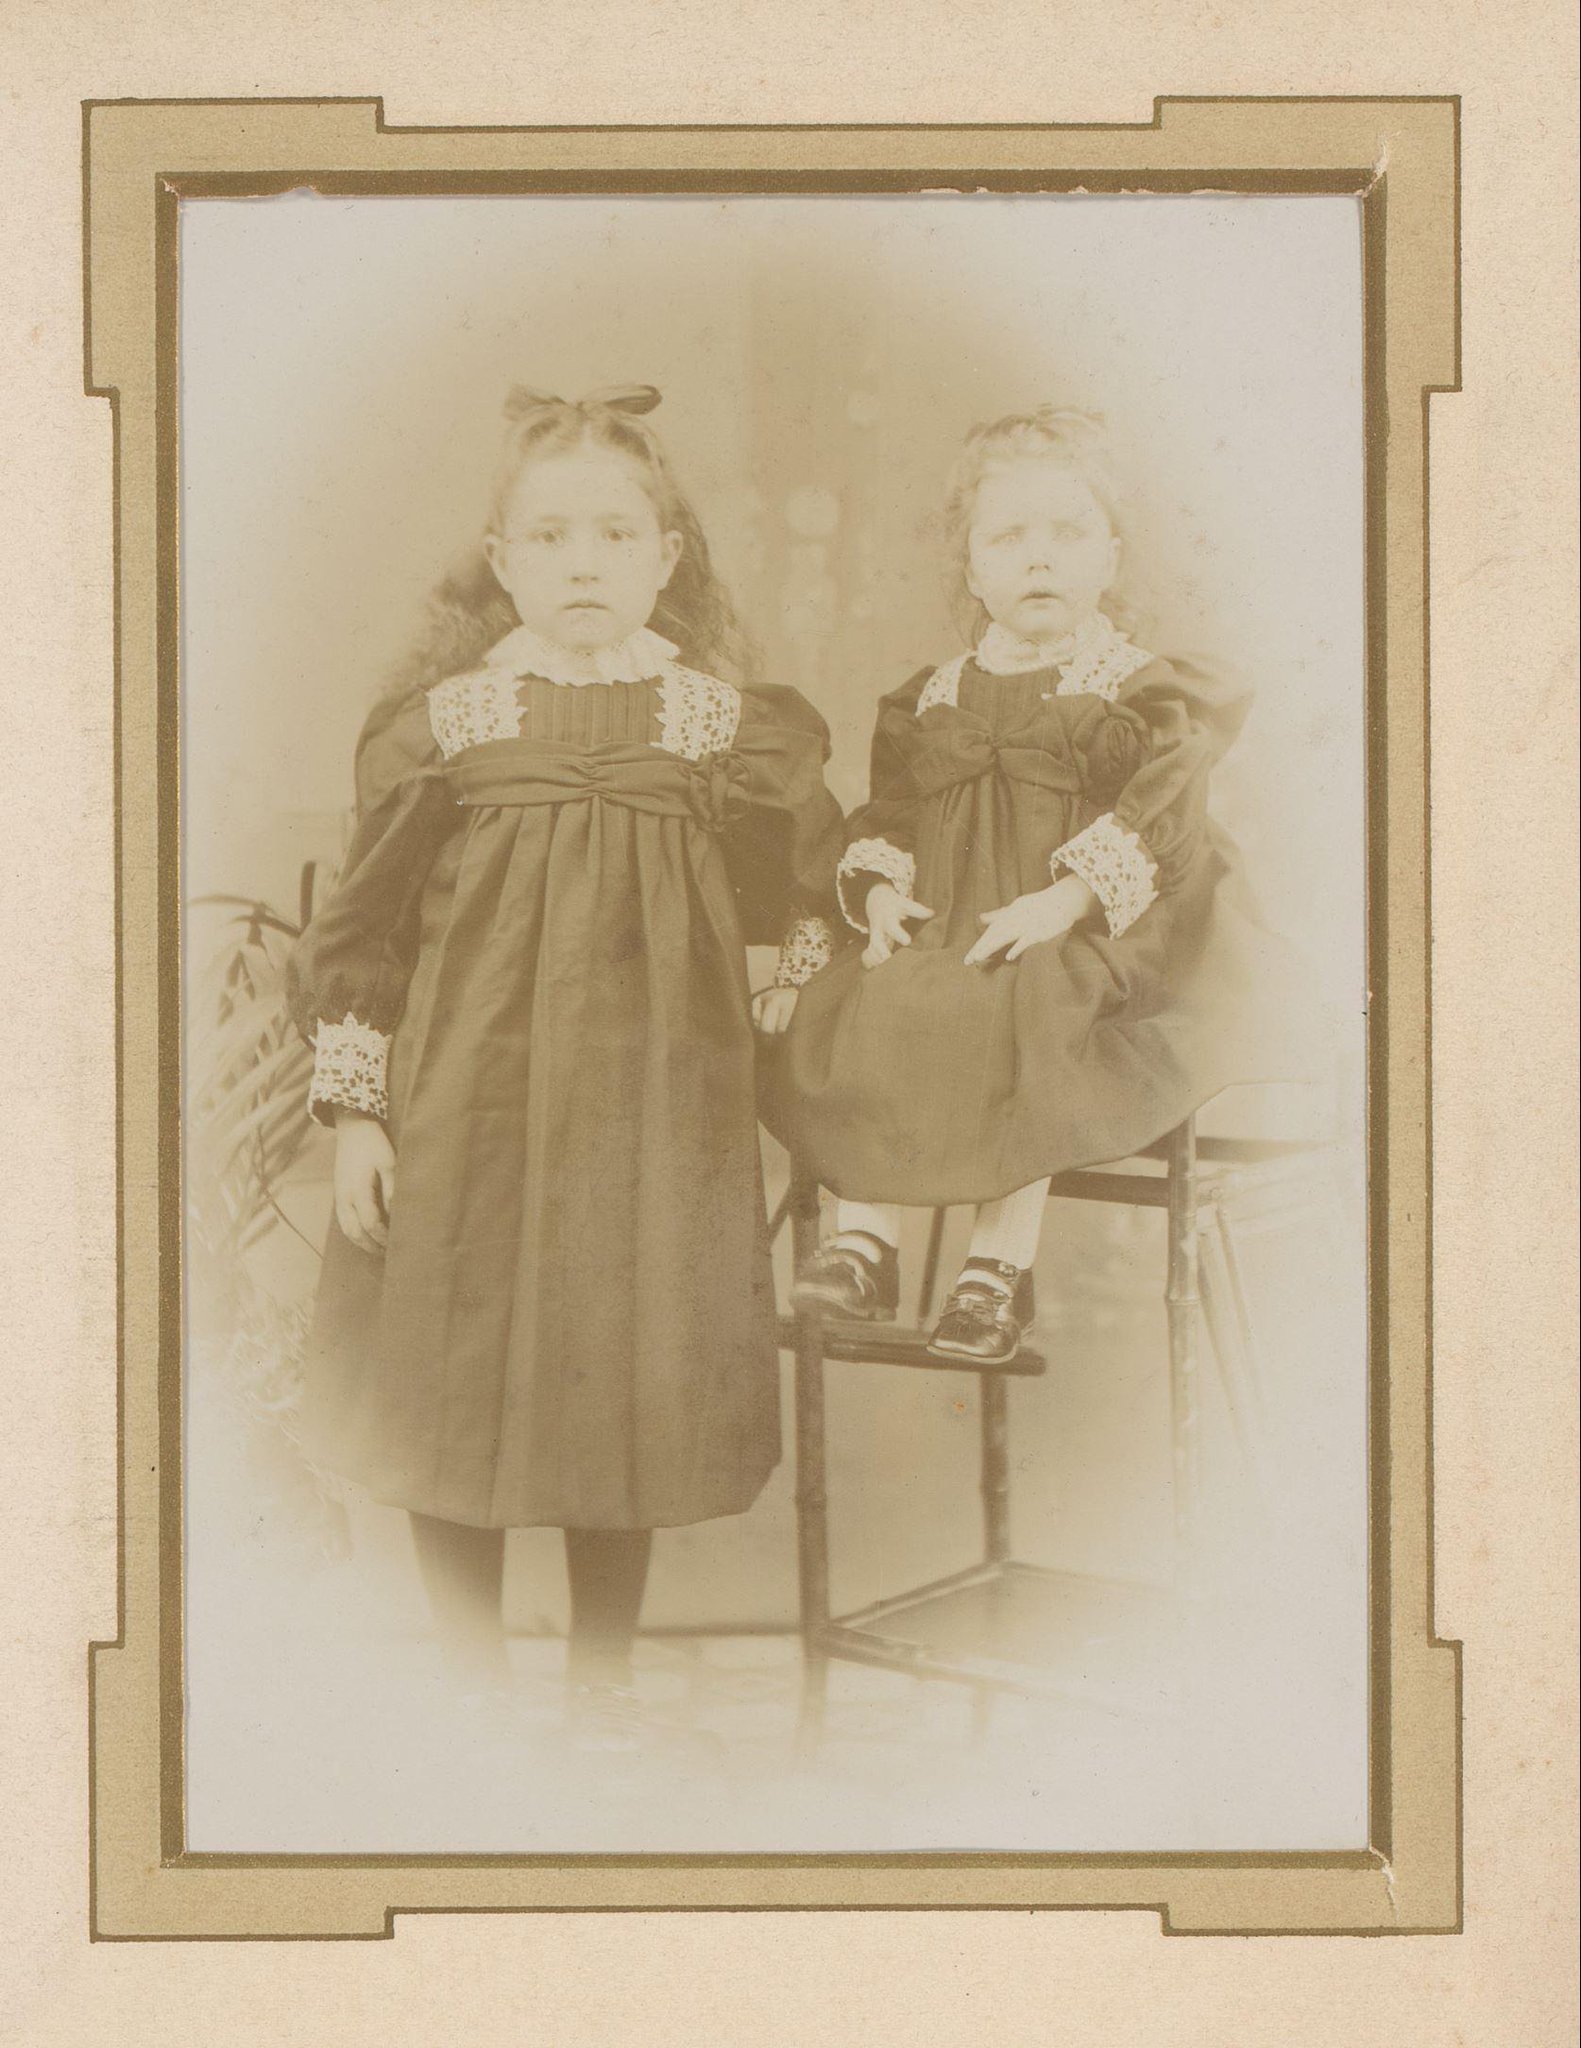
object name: photograph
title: Portret van twee meisjes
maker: j.j. gull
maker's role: fotograaf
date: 1880-1920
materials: cardboard, photographic support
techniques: gelatin silver print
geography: england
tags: historical persons - bb - woman, girl (child between toddler and youth)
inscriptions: inscription: ‘J.J. Gull/ Photographer/ Market Street/ Hetton Downs’